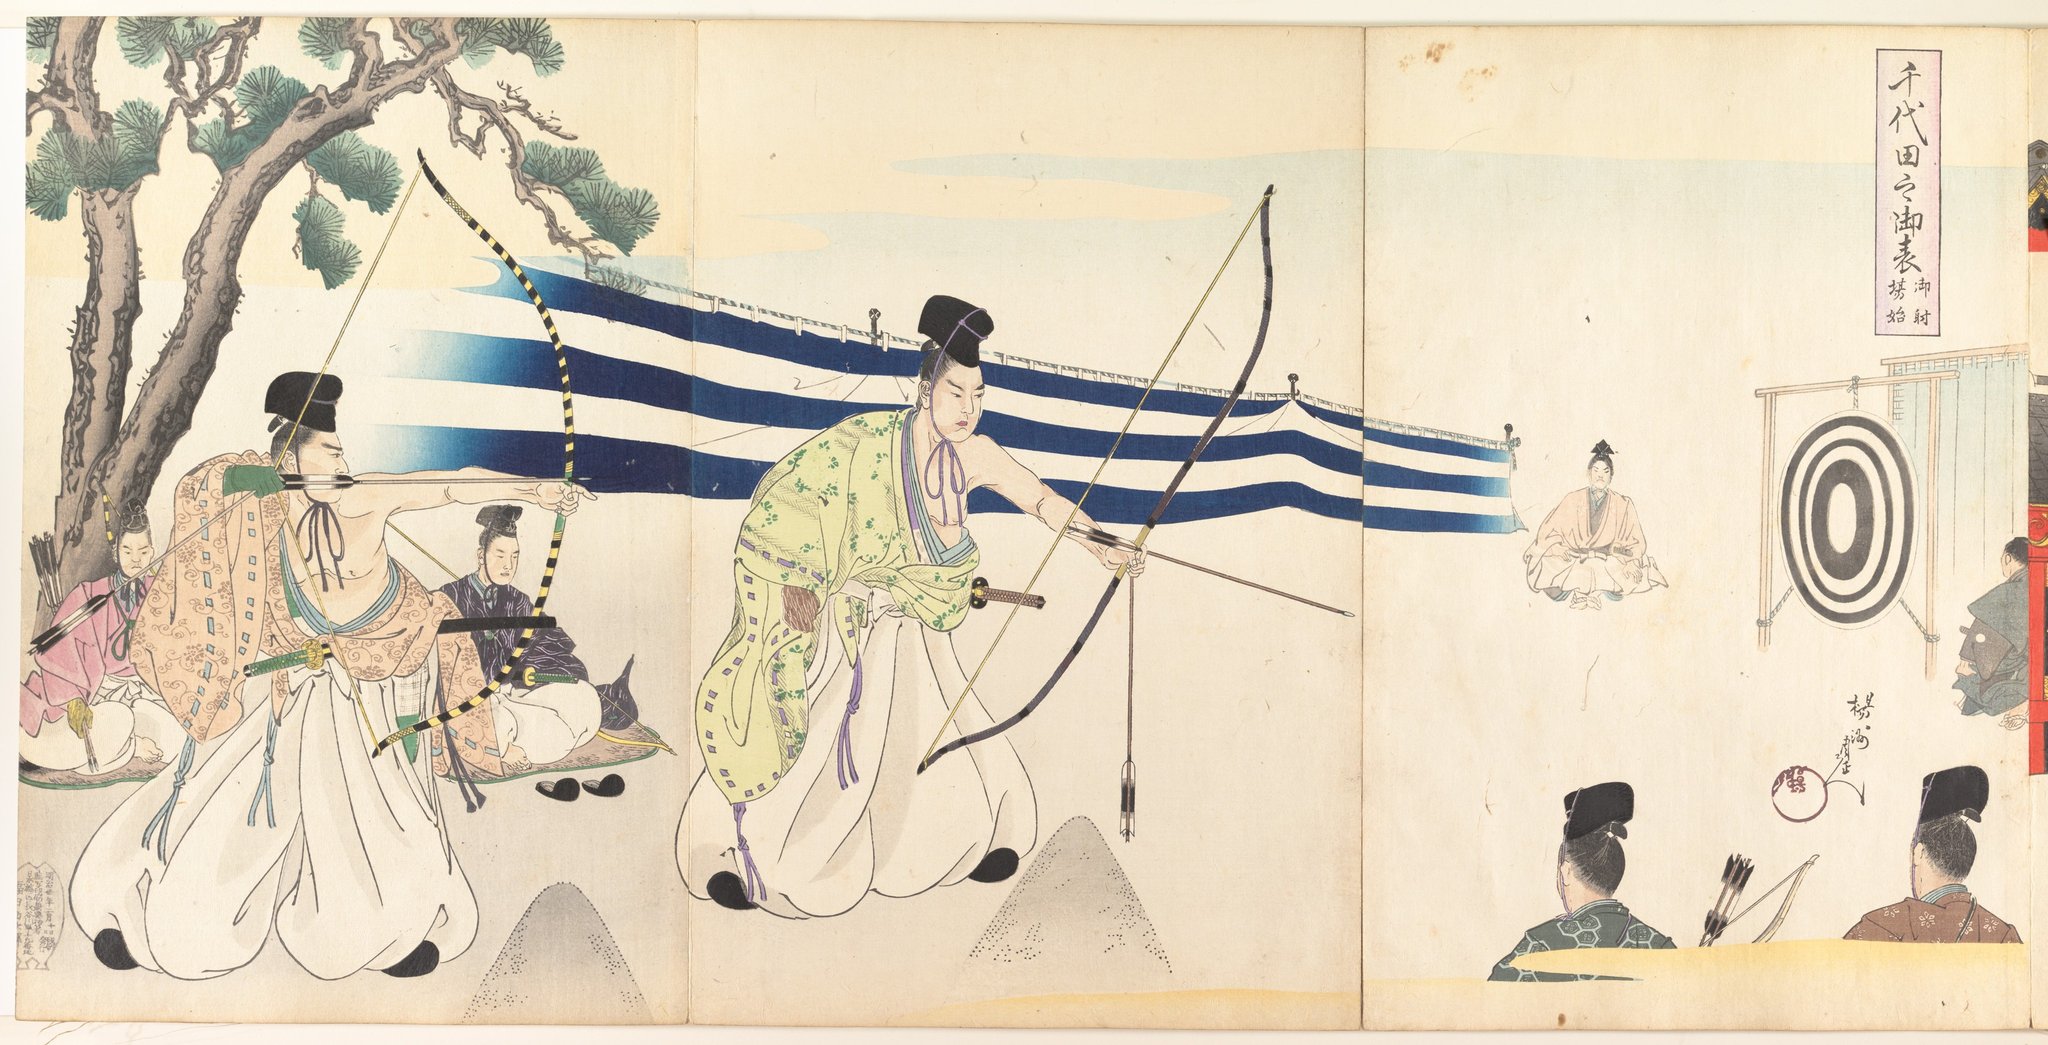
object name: print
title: Chiyoda Castle (Album of Men)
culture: japanese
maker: yōshū (hashimoto) chikanobu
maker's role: artist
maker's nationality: japanese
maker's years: 1838-1912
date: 1897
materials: ink, paper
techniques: woodblock print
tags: bow and arrow,men,sports,trees